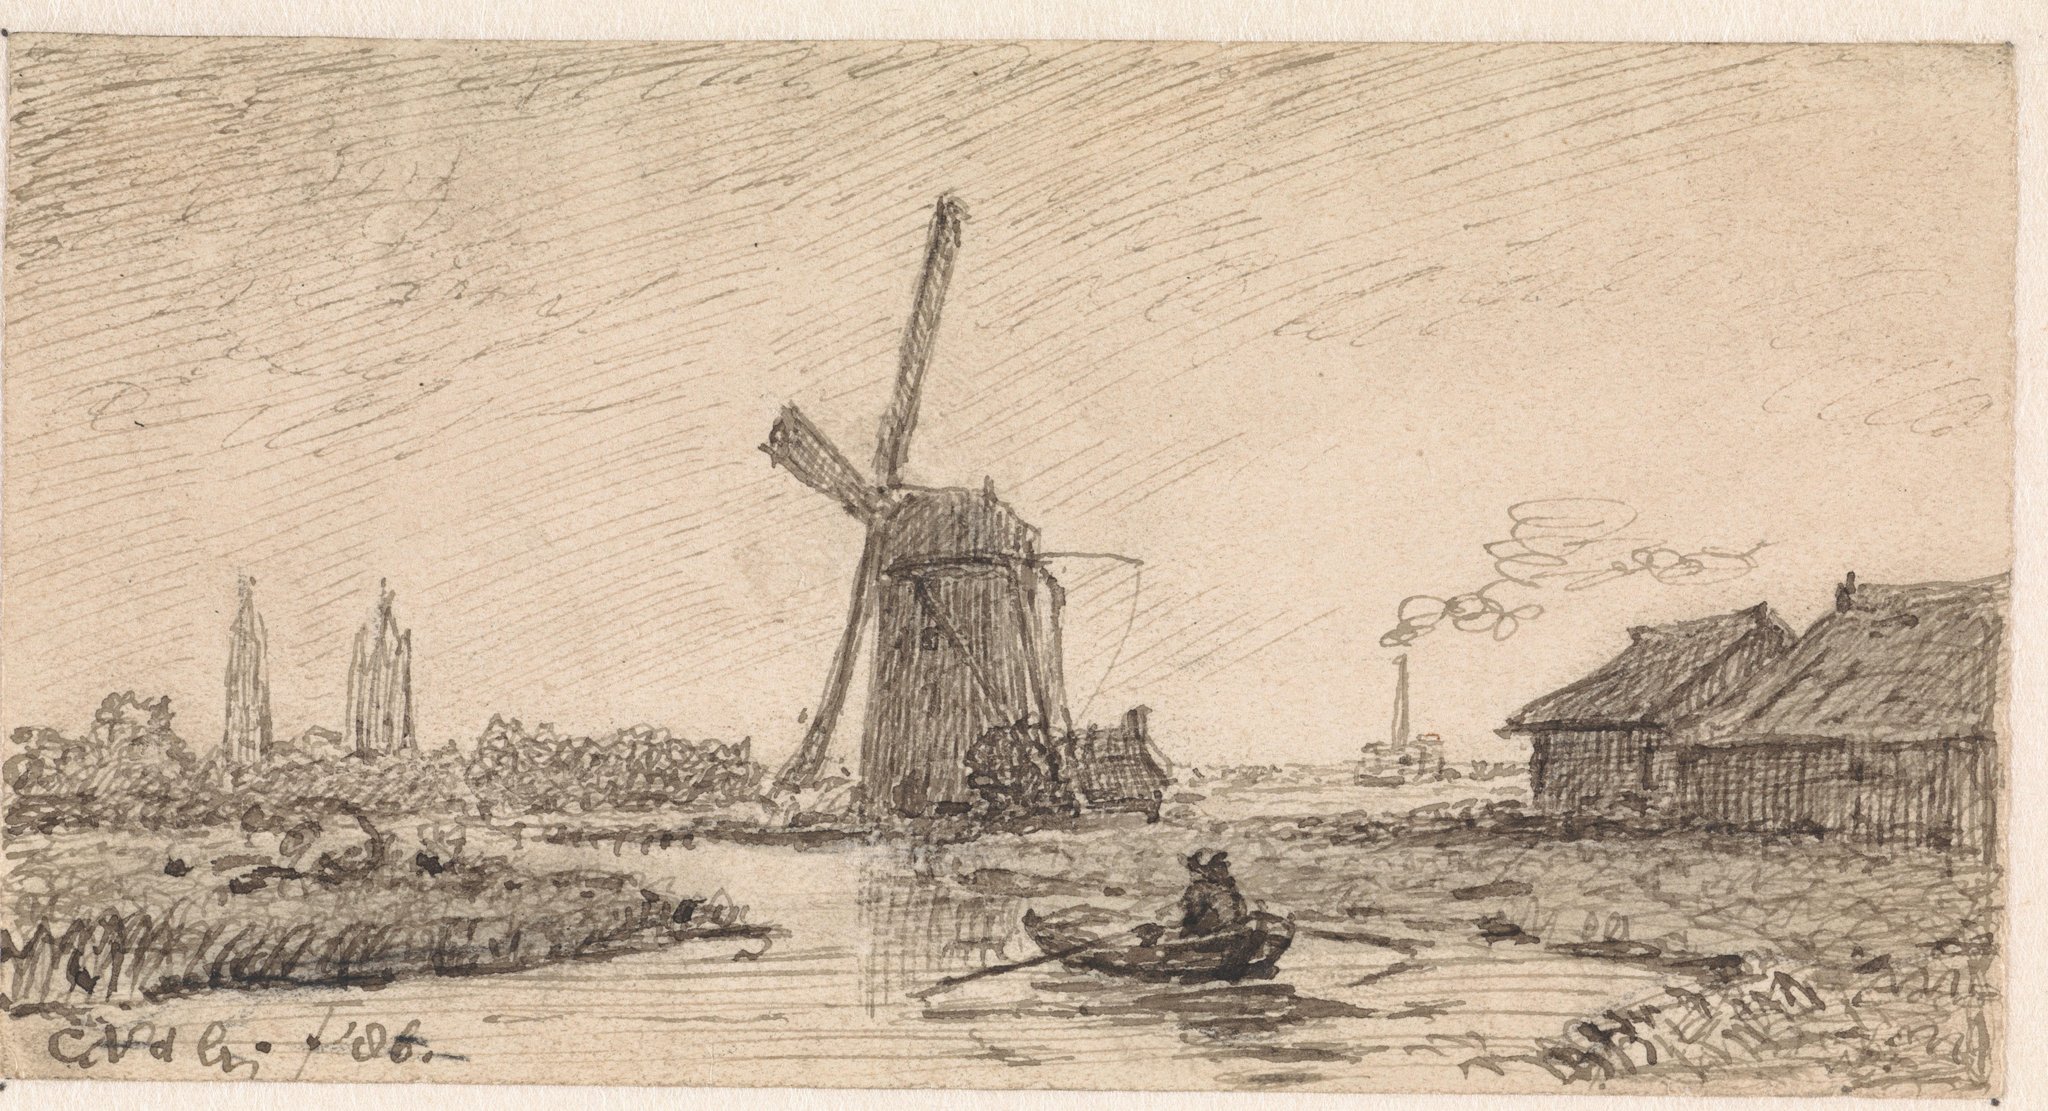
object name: drawing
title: Rivierlandschap bij Nootdorp, in de verte Delft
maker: cornelis van der griendt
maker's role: draughtsman, painter, print maker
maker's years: 1827-1918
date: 1886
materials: ink, paper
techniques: pen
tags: landscapes with waters, waterscapes, seascapes (in the temperate zone), windmill, delft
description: In de veenen bij Nootdorp, gezicht op Delft.